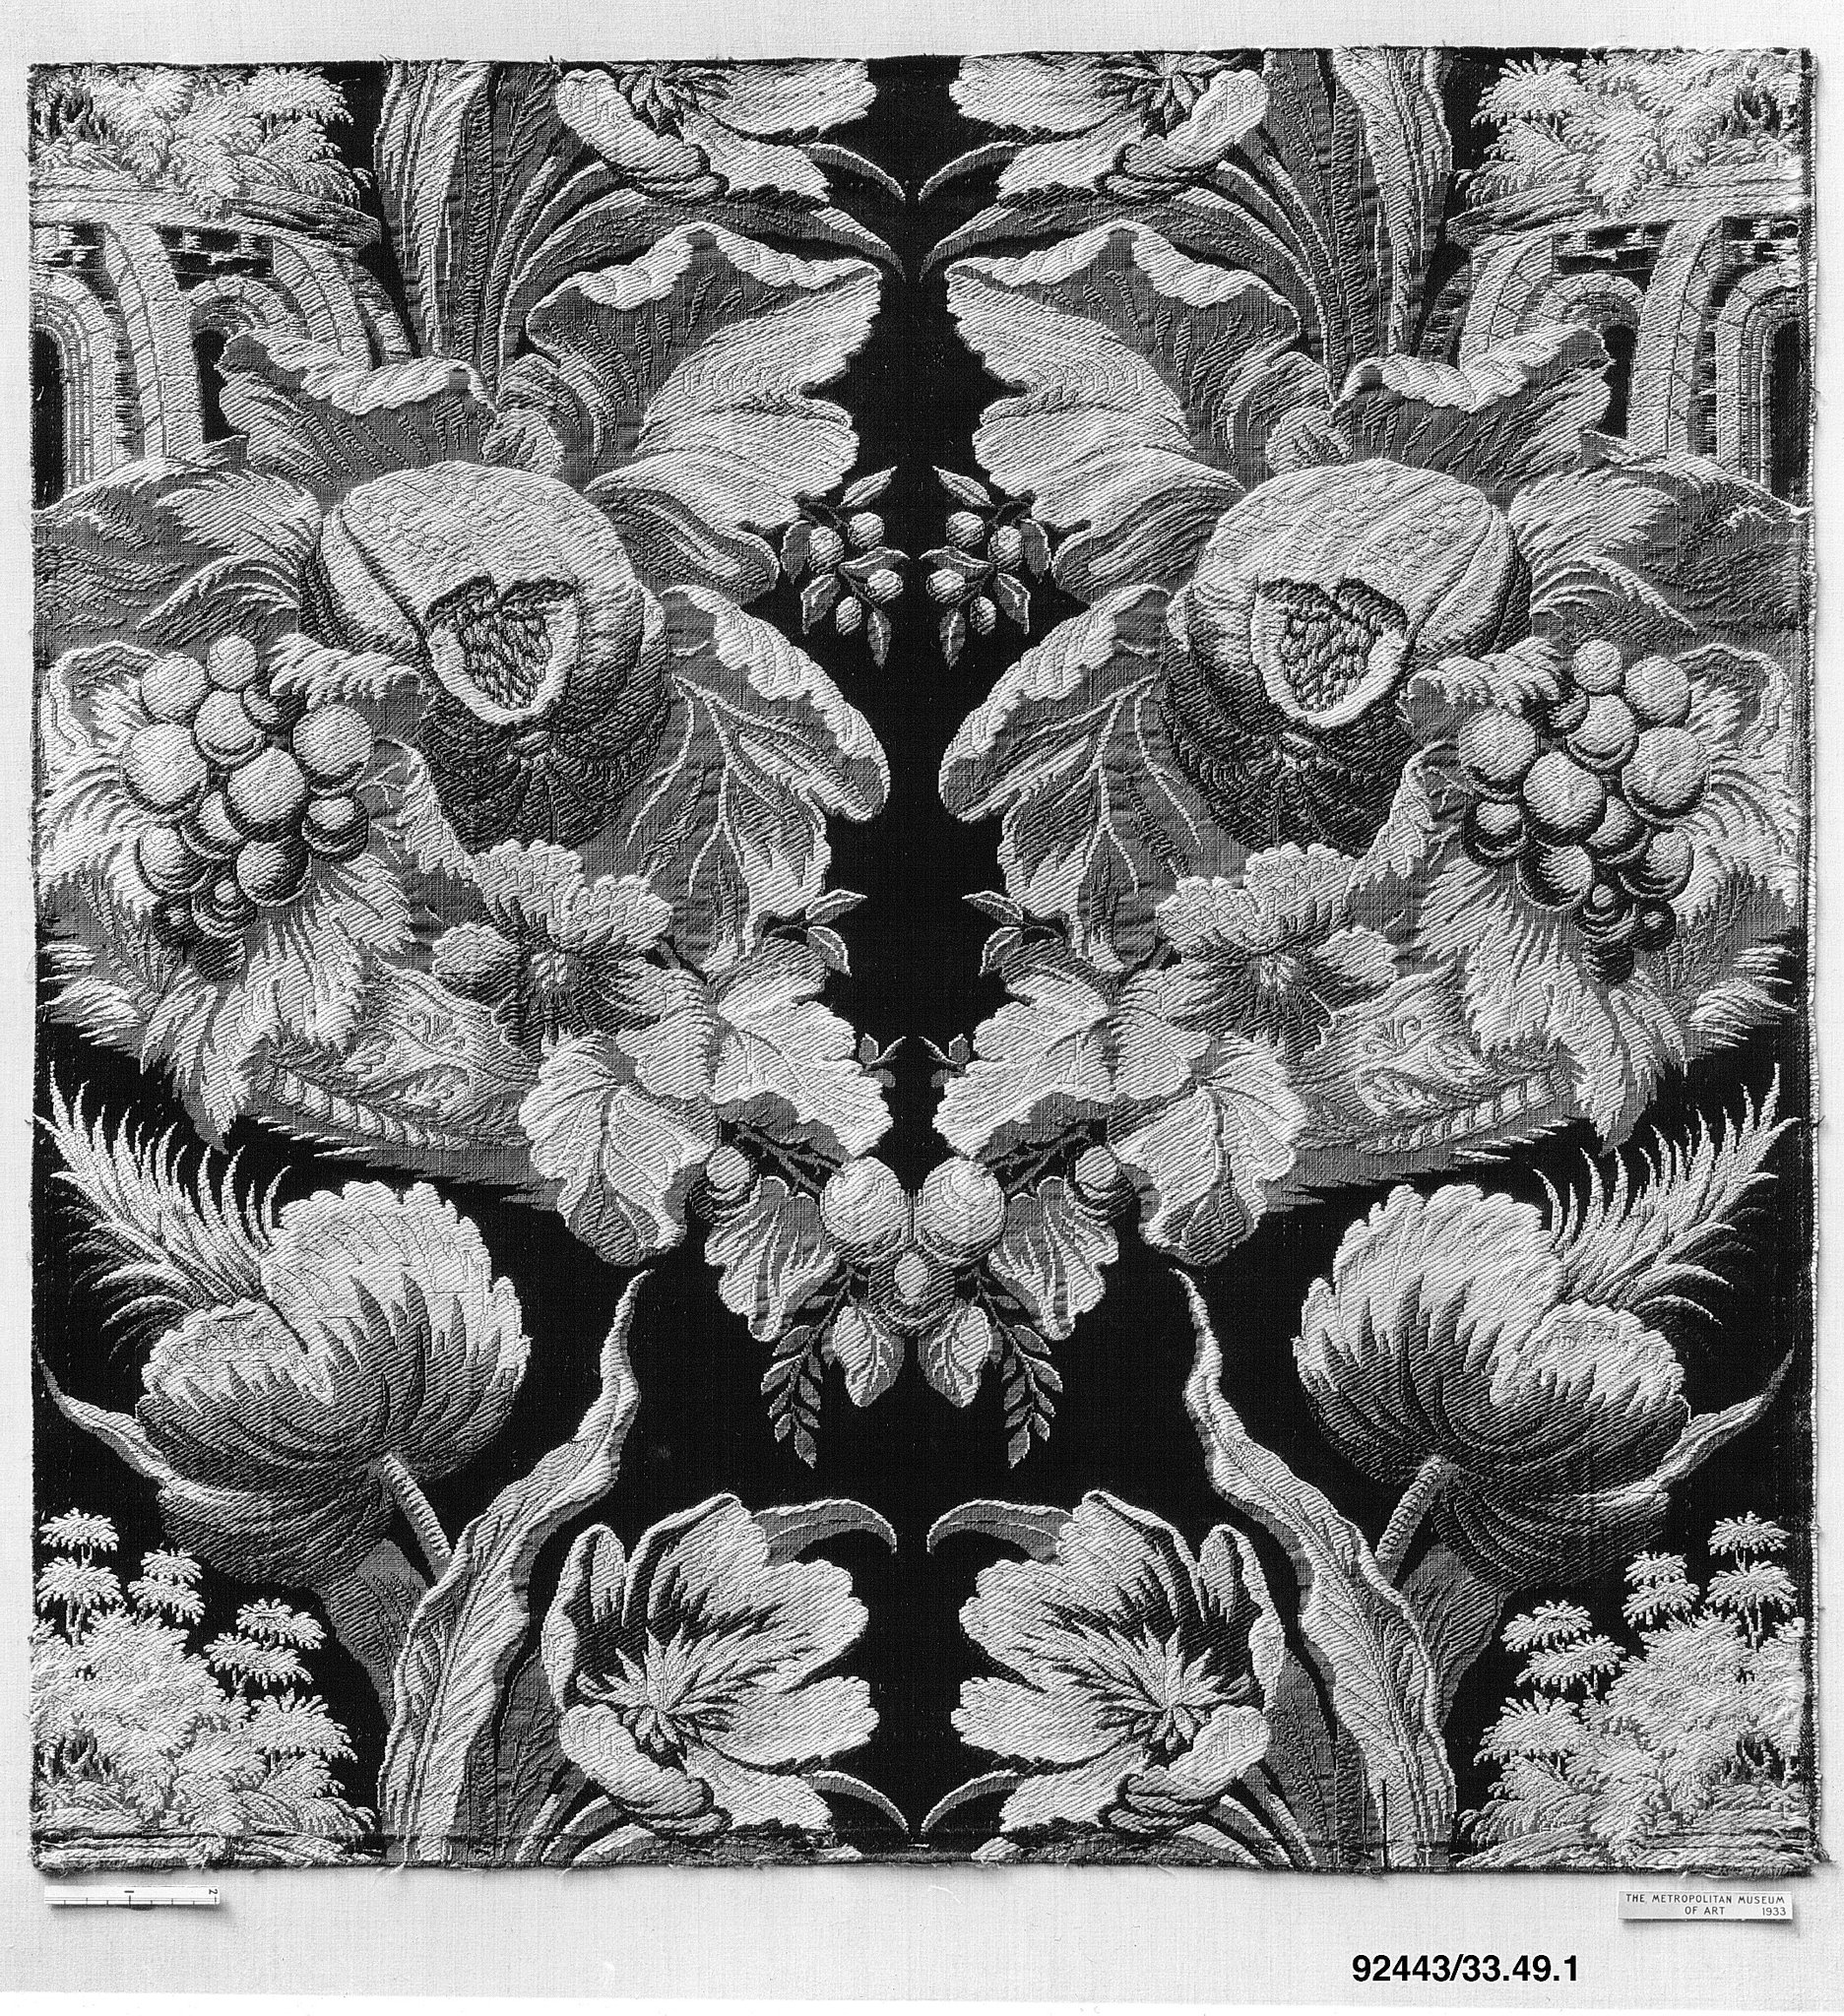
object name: fragment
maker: jean revel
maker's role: designer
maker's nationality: french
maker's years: 1684-1751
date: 1701-1733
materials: silk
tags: flowers,leaves